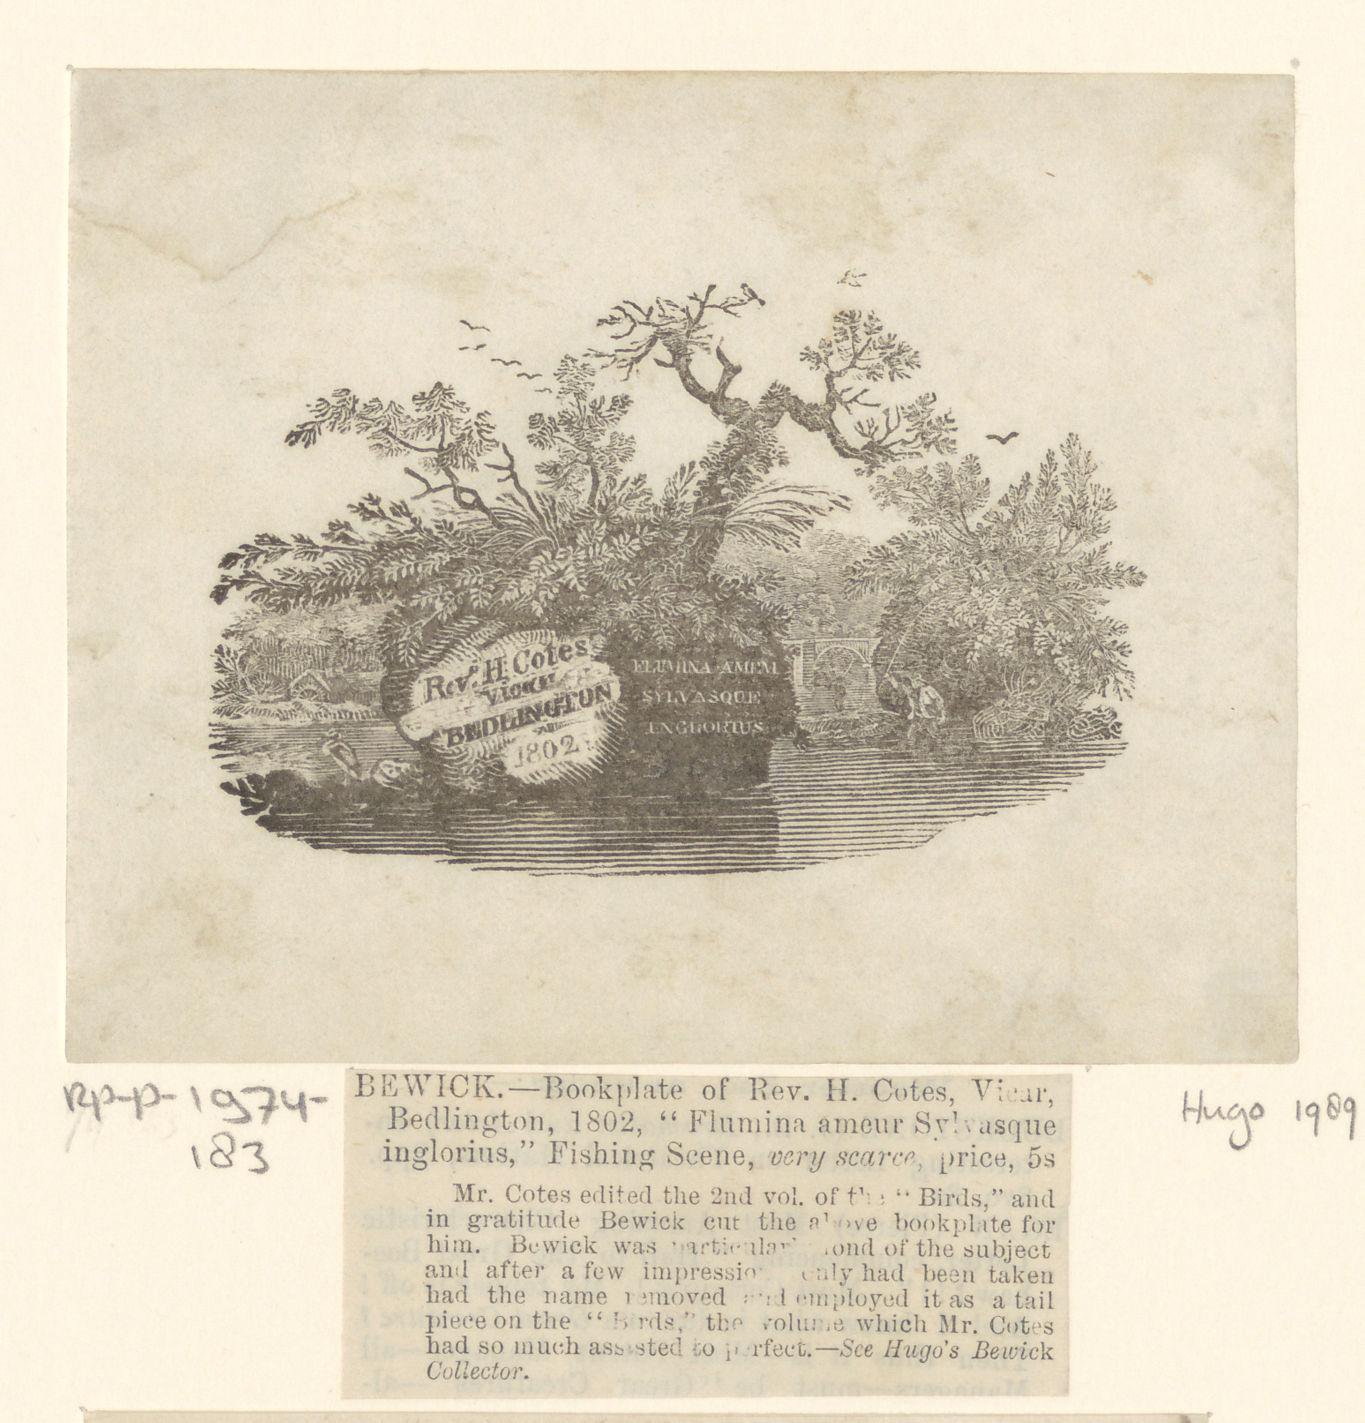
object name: print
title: Ex libris van H. Cotes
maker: thomas bewick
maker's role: draughtsman, painter, print maker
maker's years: 1753-1828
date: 1802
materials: paper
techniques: engraving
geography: great britain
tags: shrubs, landscapes with waters, waterscapes, seascapes (in the temperate zone)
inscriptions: collector's mark: Lugt 2228